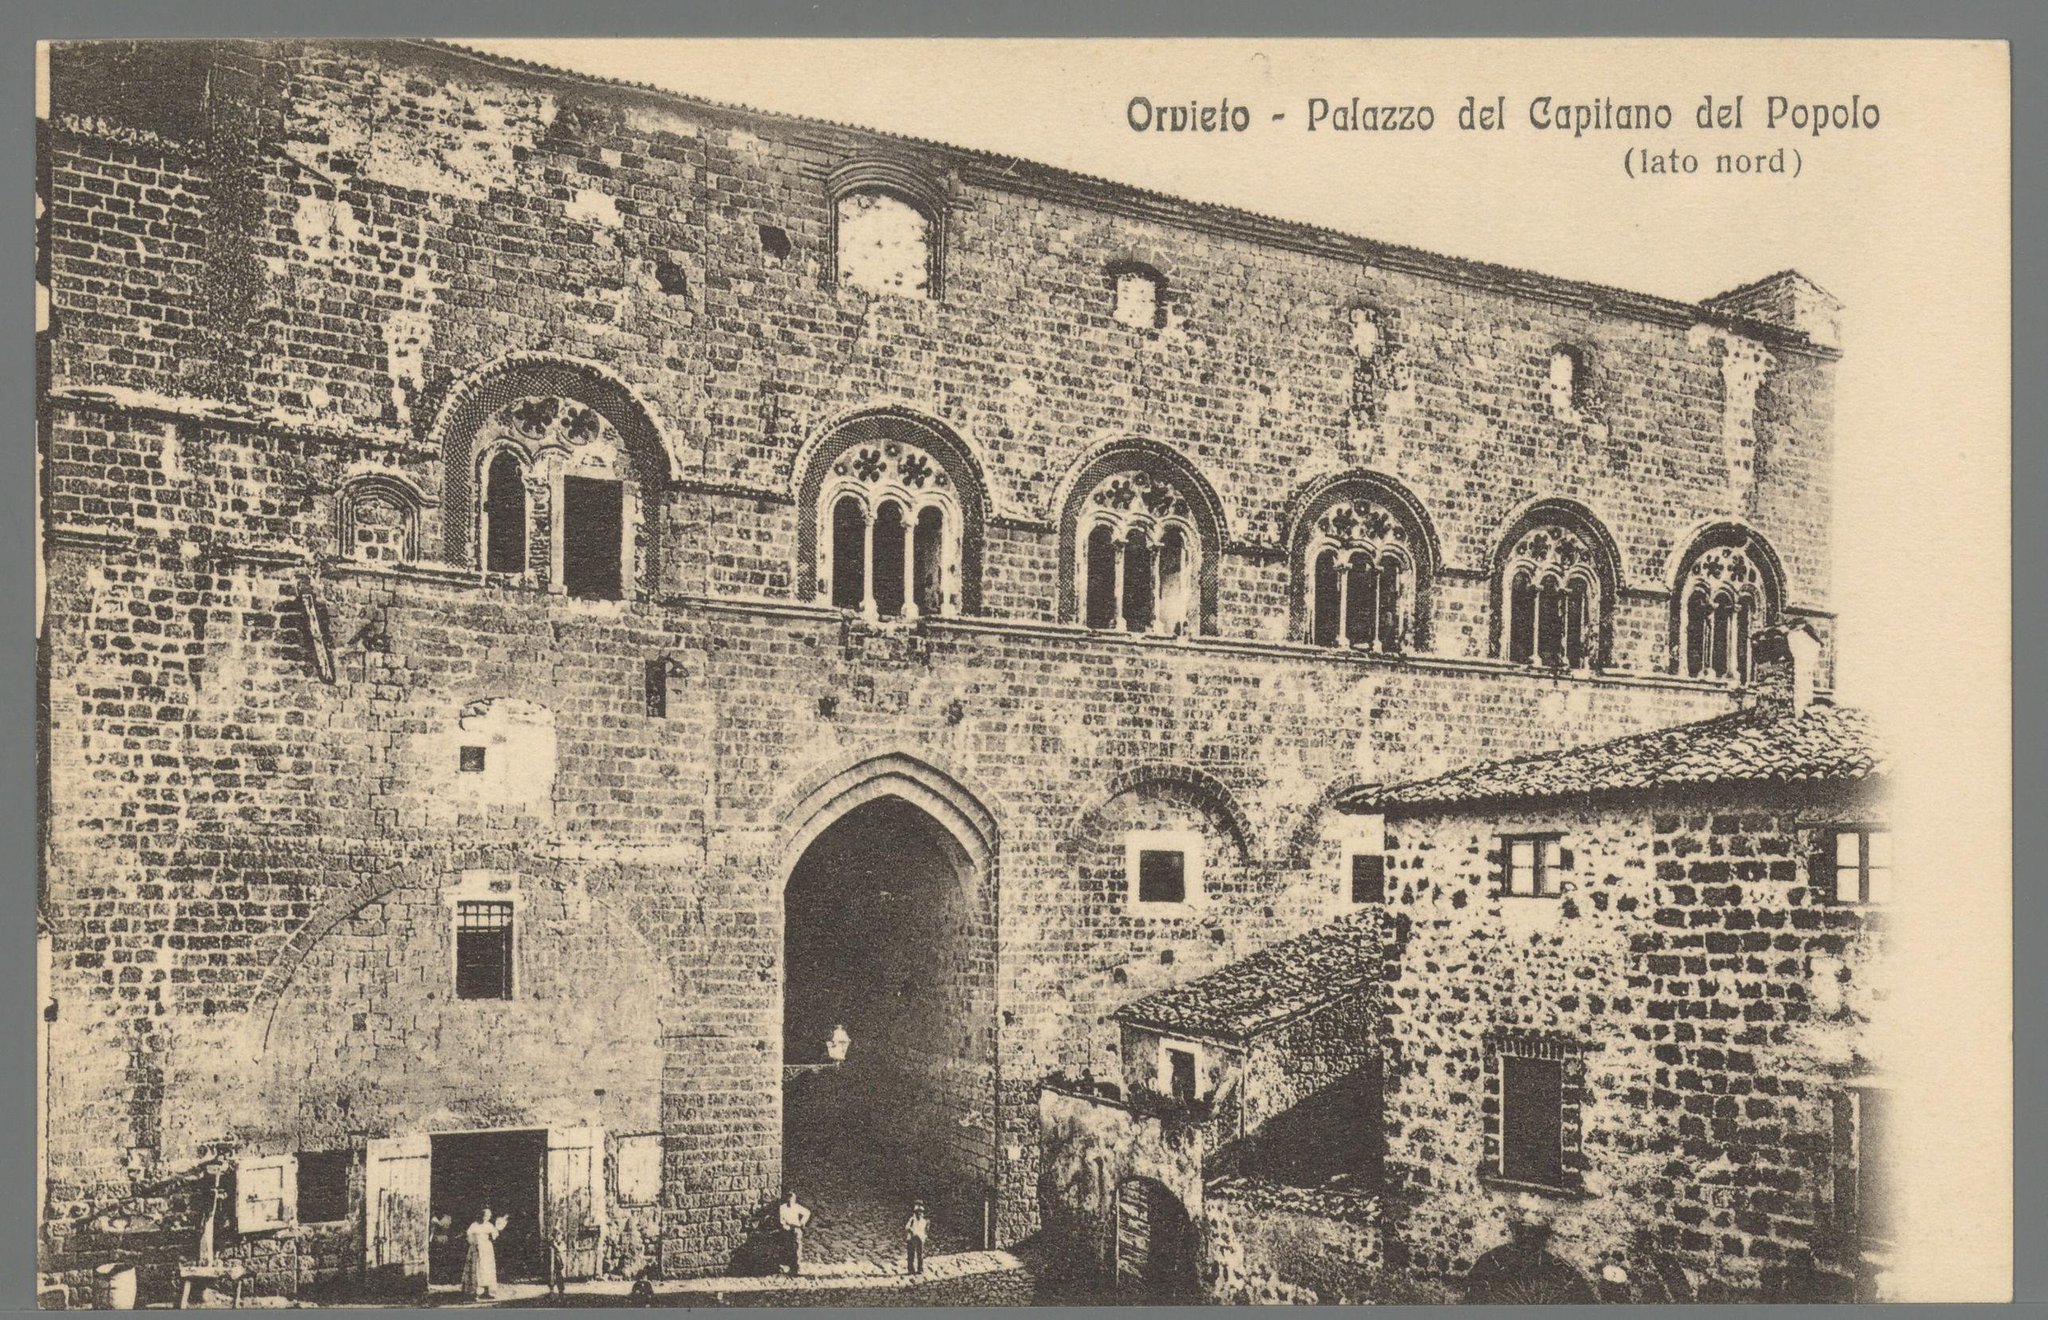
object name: ansichtkaart, prentbriefkaart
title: Orvieto. Palazzo del Capitano del Populo (lato nord)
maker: Anonymous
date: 1906-1910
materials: cardboard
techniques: photograph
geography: terni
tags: palace, square, place, circus, etc. (+ city(-scape) with figures, staffage)